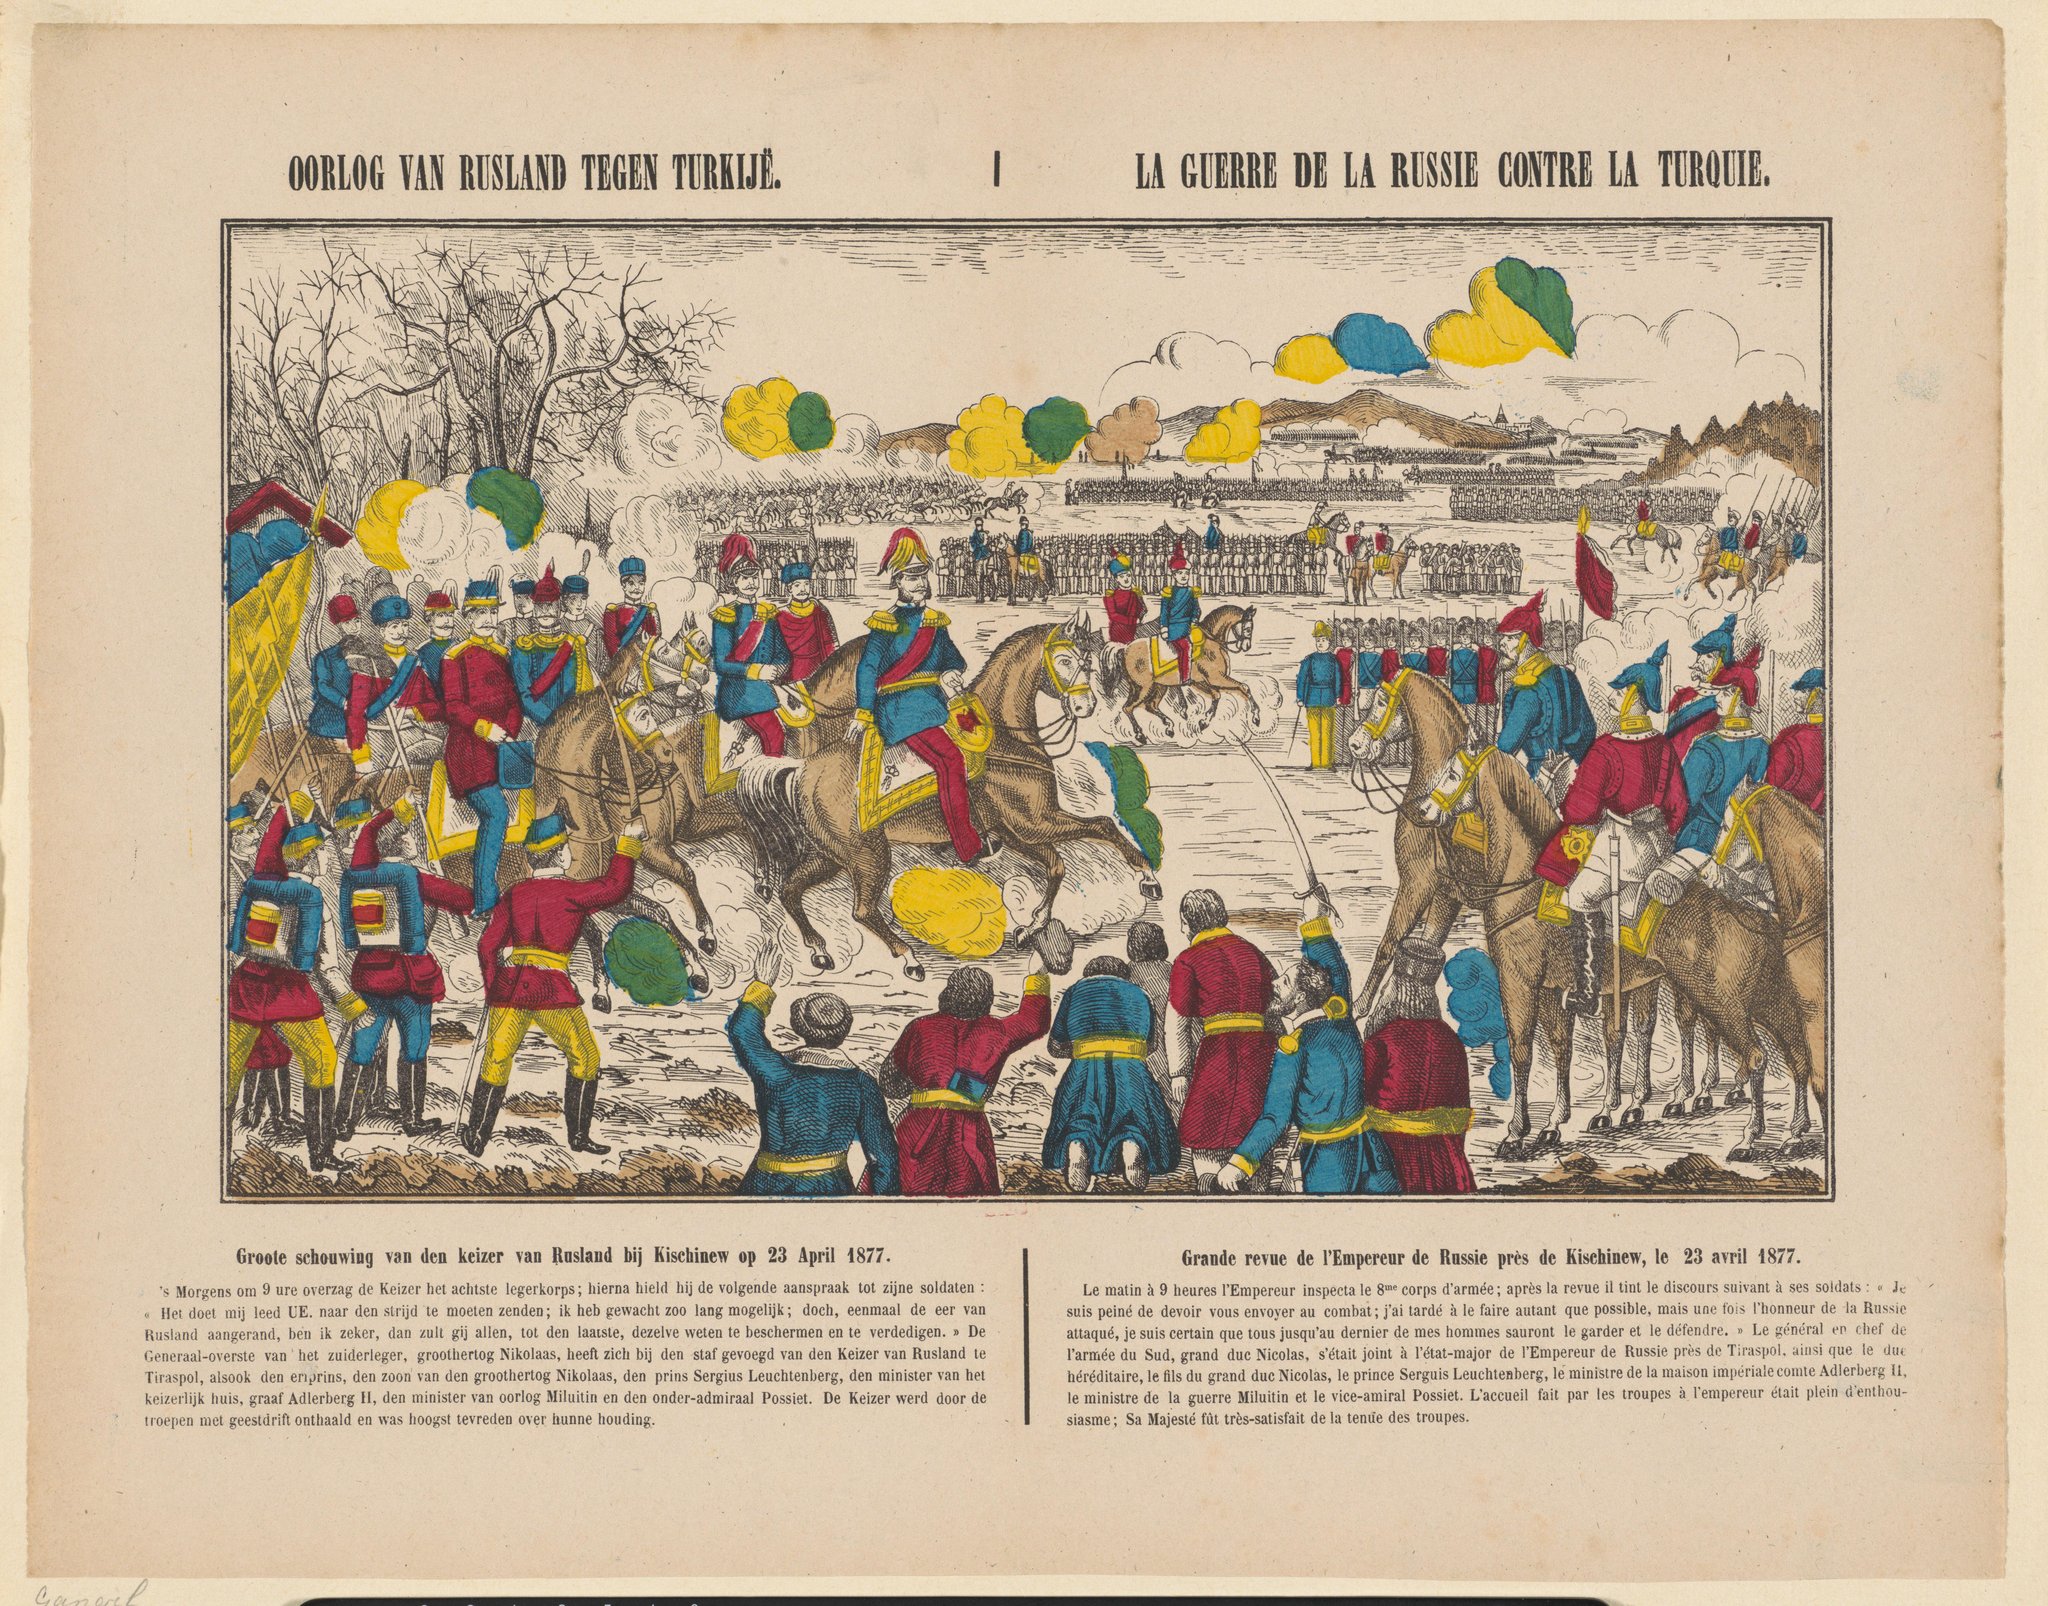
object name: print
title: Oorlog van Rusland tegen Turkijë / La guerre de la Russie contre la Turquie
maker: Anonymous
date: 1877-1879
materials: paper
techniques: hand coloring, letterpress printing, lithograph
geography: metz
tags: asiatic races and peoples: turks, battle, warfare; military affairs (+ cavalry, horsemen), war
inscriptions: collector's mark: Lugt 2760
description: Tsaar Alexander II inspecteert te paard zijn troepen en spreekt hen moed in, voordat ze de strijd tegen de Turken ingaan (Groote schouwing van den keizer van Rusland bij Kischinew op 23 april 1877). Onder de afbeelding een titel en een zevenregelig onderschrift in het Nederlands en in het Frans.